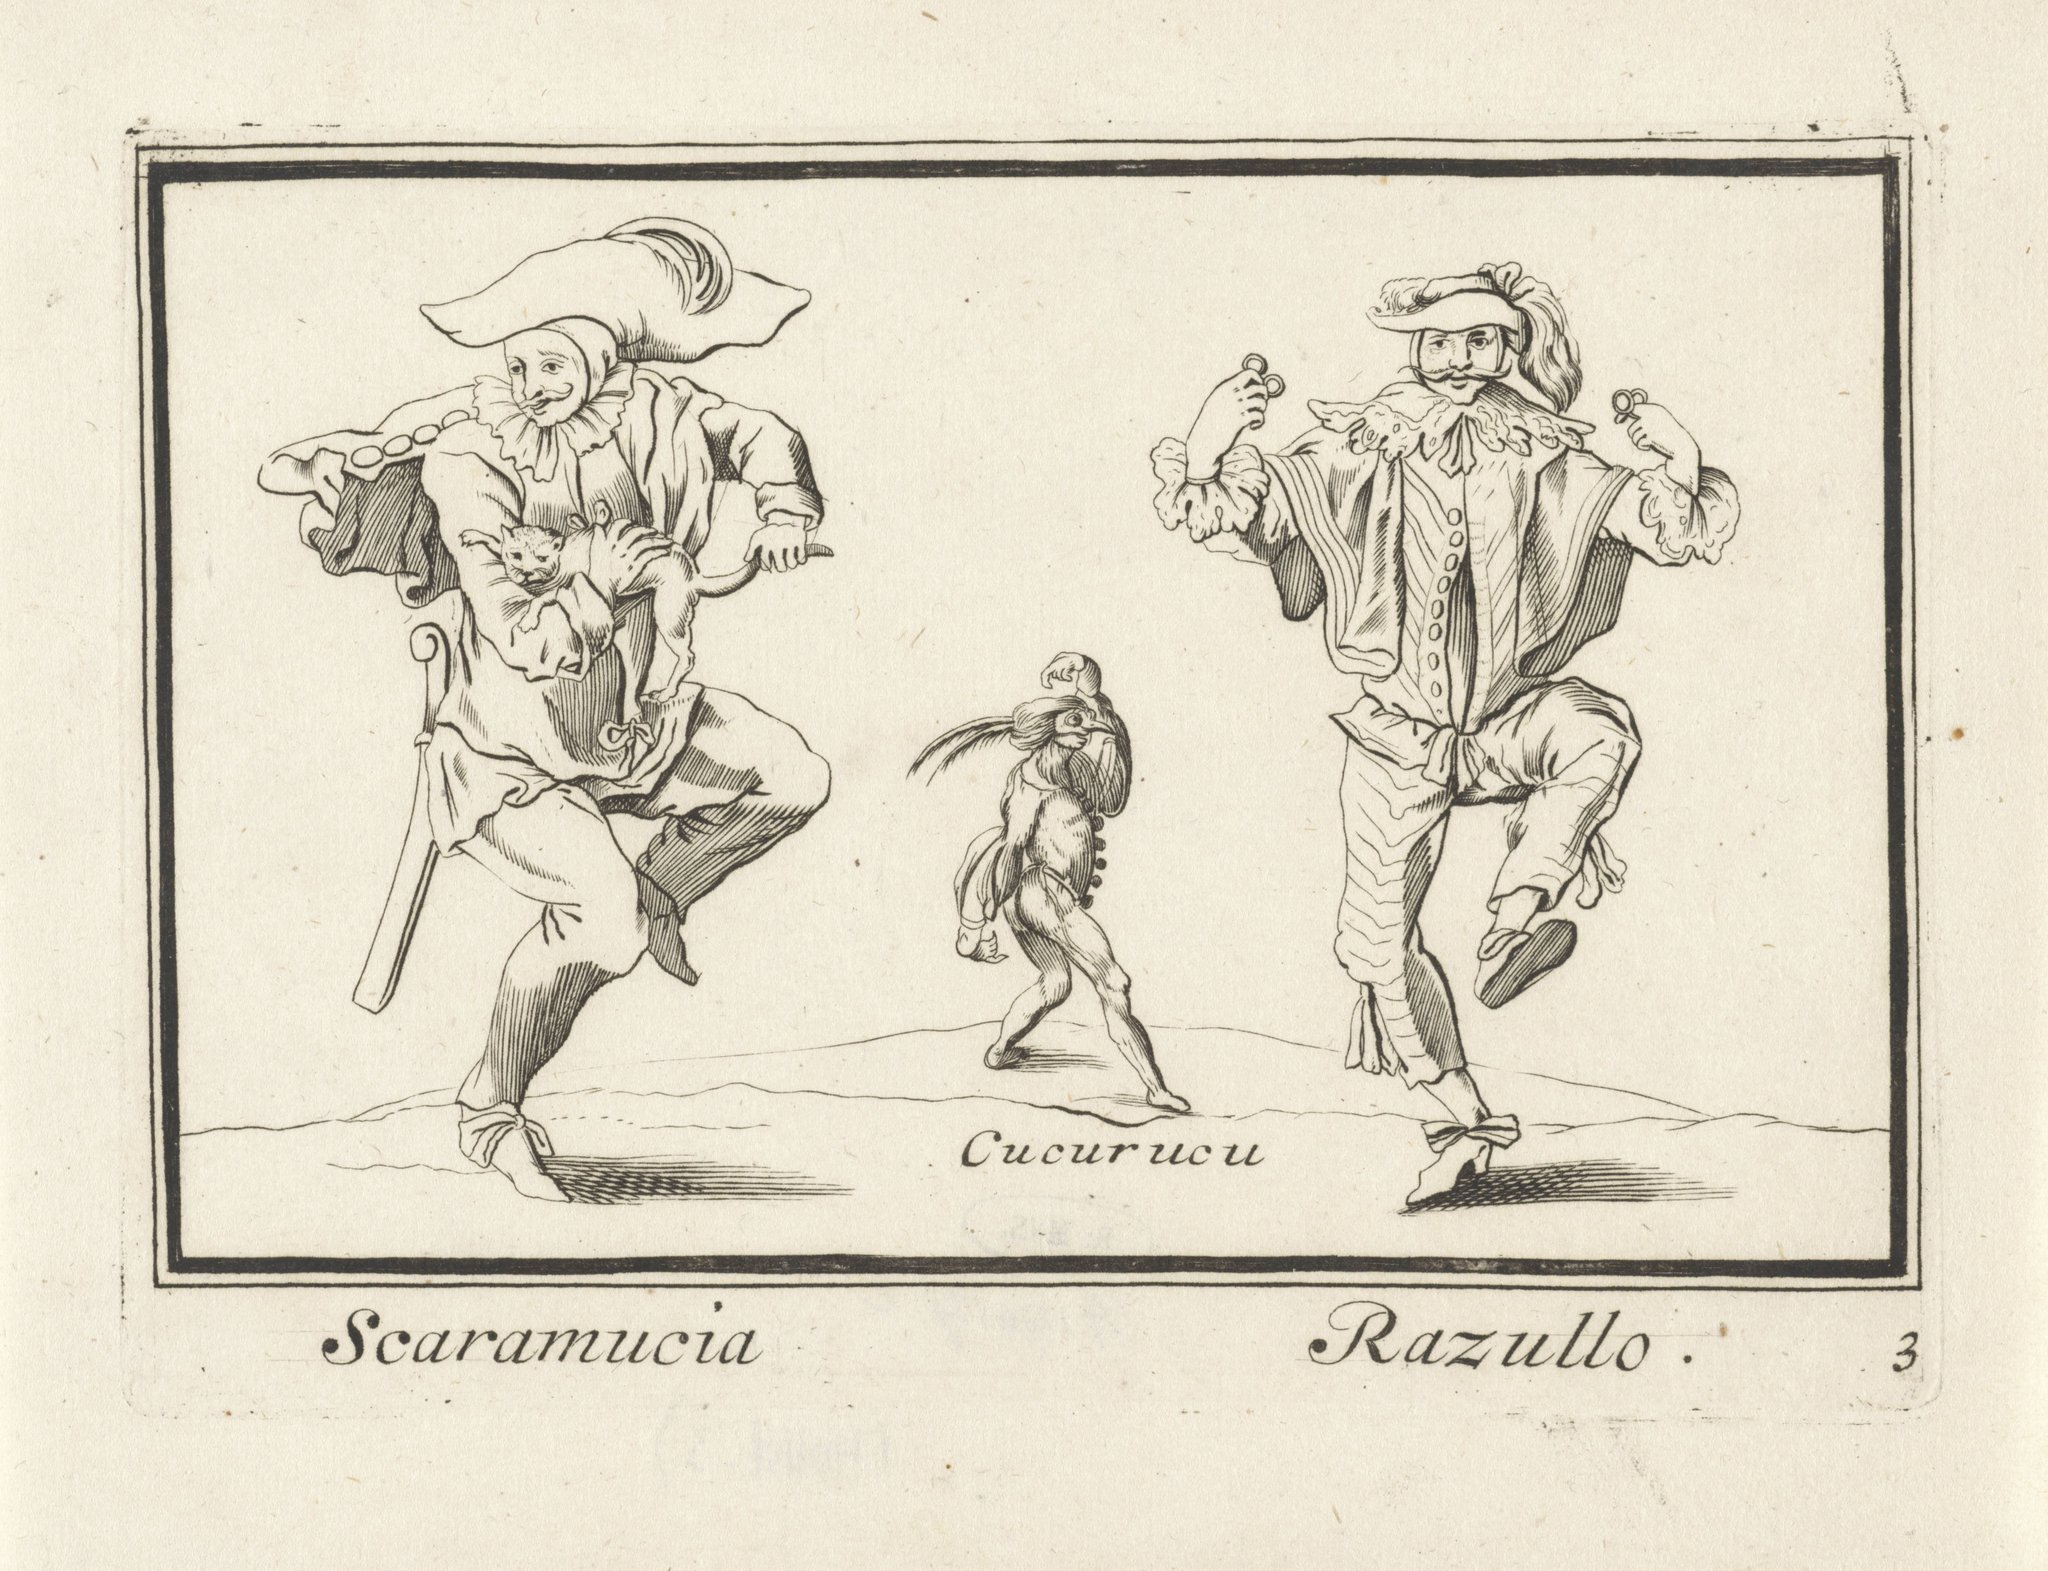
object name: print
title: Scaramouche, Cucurucu en Razullo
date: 1668-1707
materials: paper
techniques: etching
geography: amsterdam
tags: types in 'commedia dell'arte'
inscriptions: collector's mark: Lugt 2228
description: Drie personages uit de commedia dell'arte. Links Scaramouche met een kat op zijn arm. In het midden Cucurucu. Rechts Razullo, balancerend op één been met in beide handen een pince-nez(?)